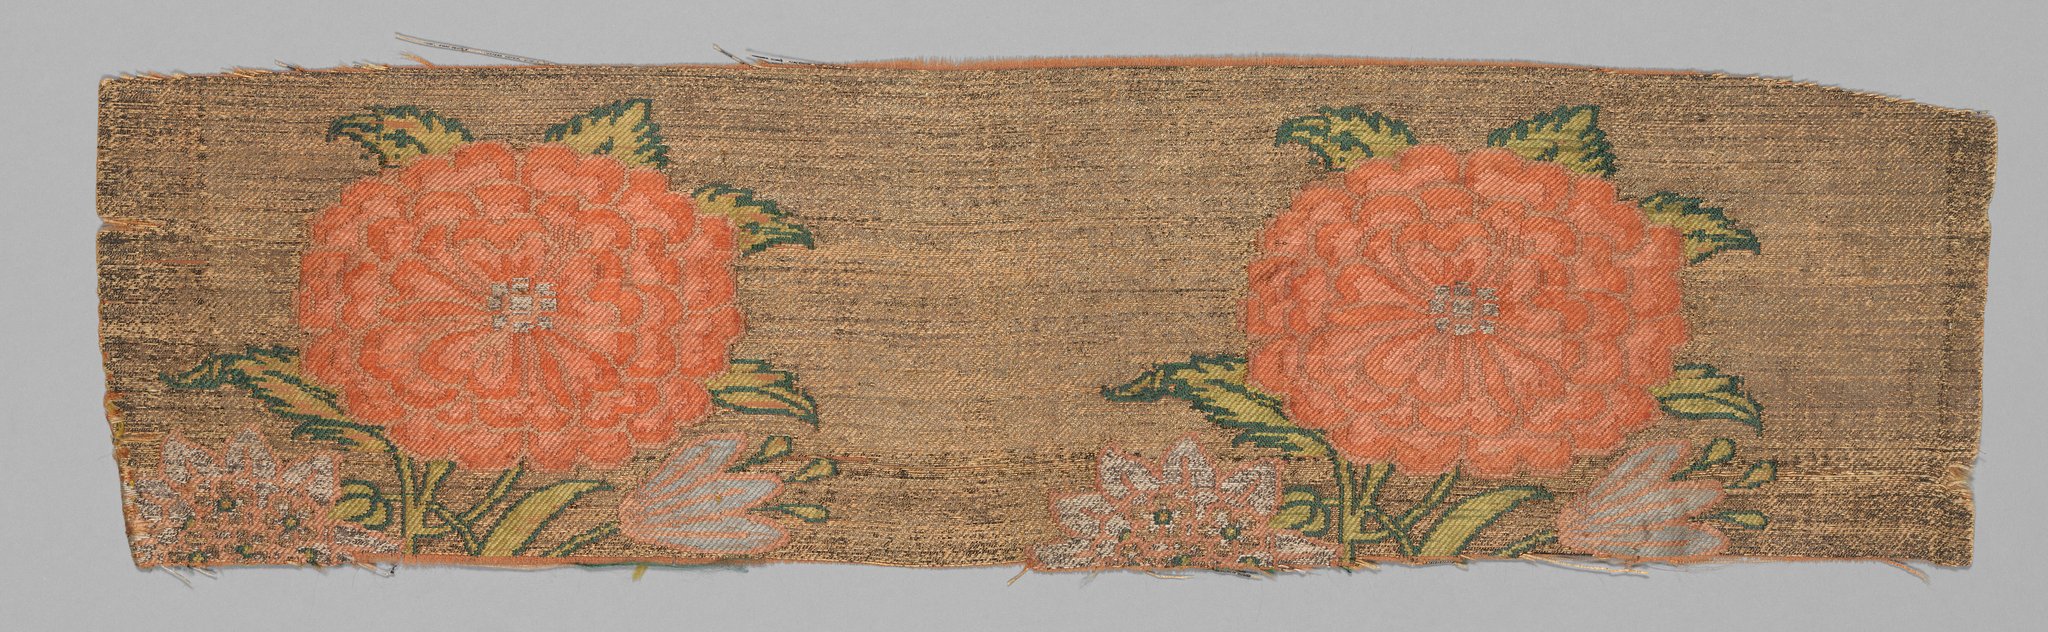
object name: textile fragment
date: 1601-1700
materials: metal thread, silk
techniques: brocade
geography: iran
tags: flowers